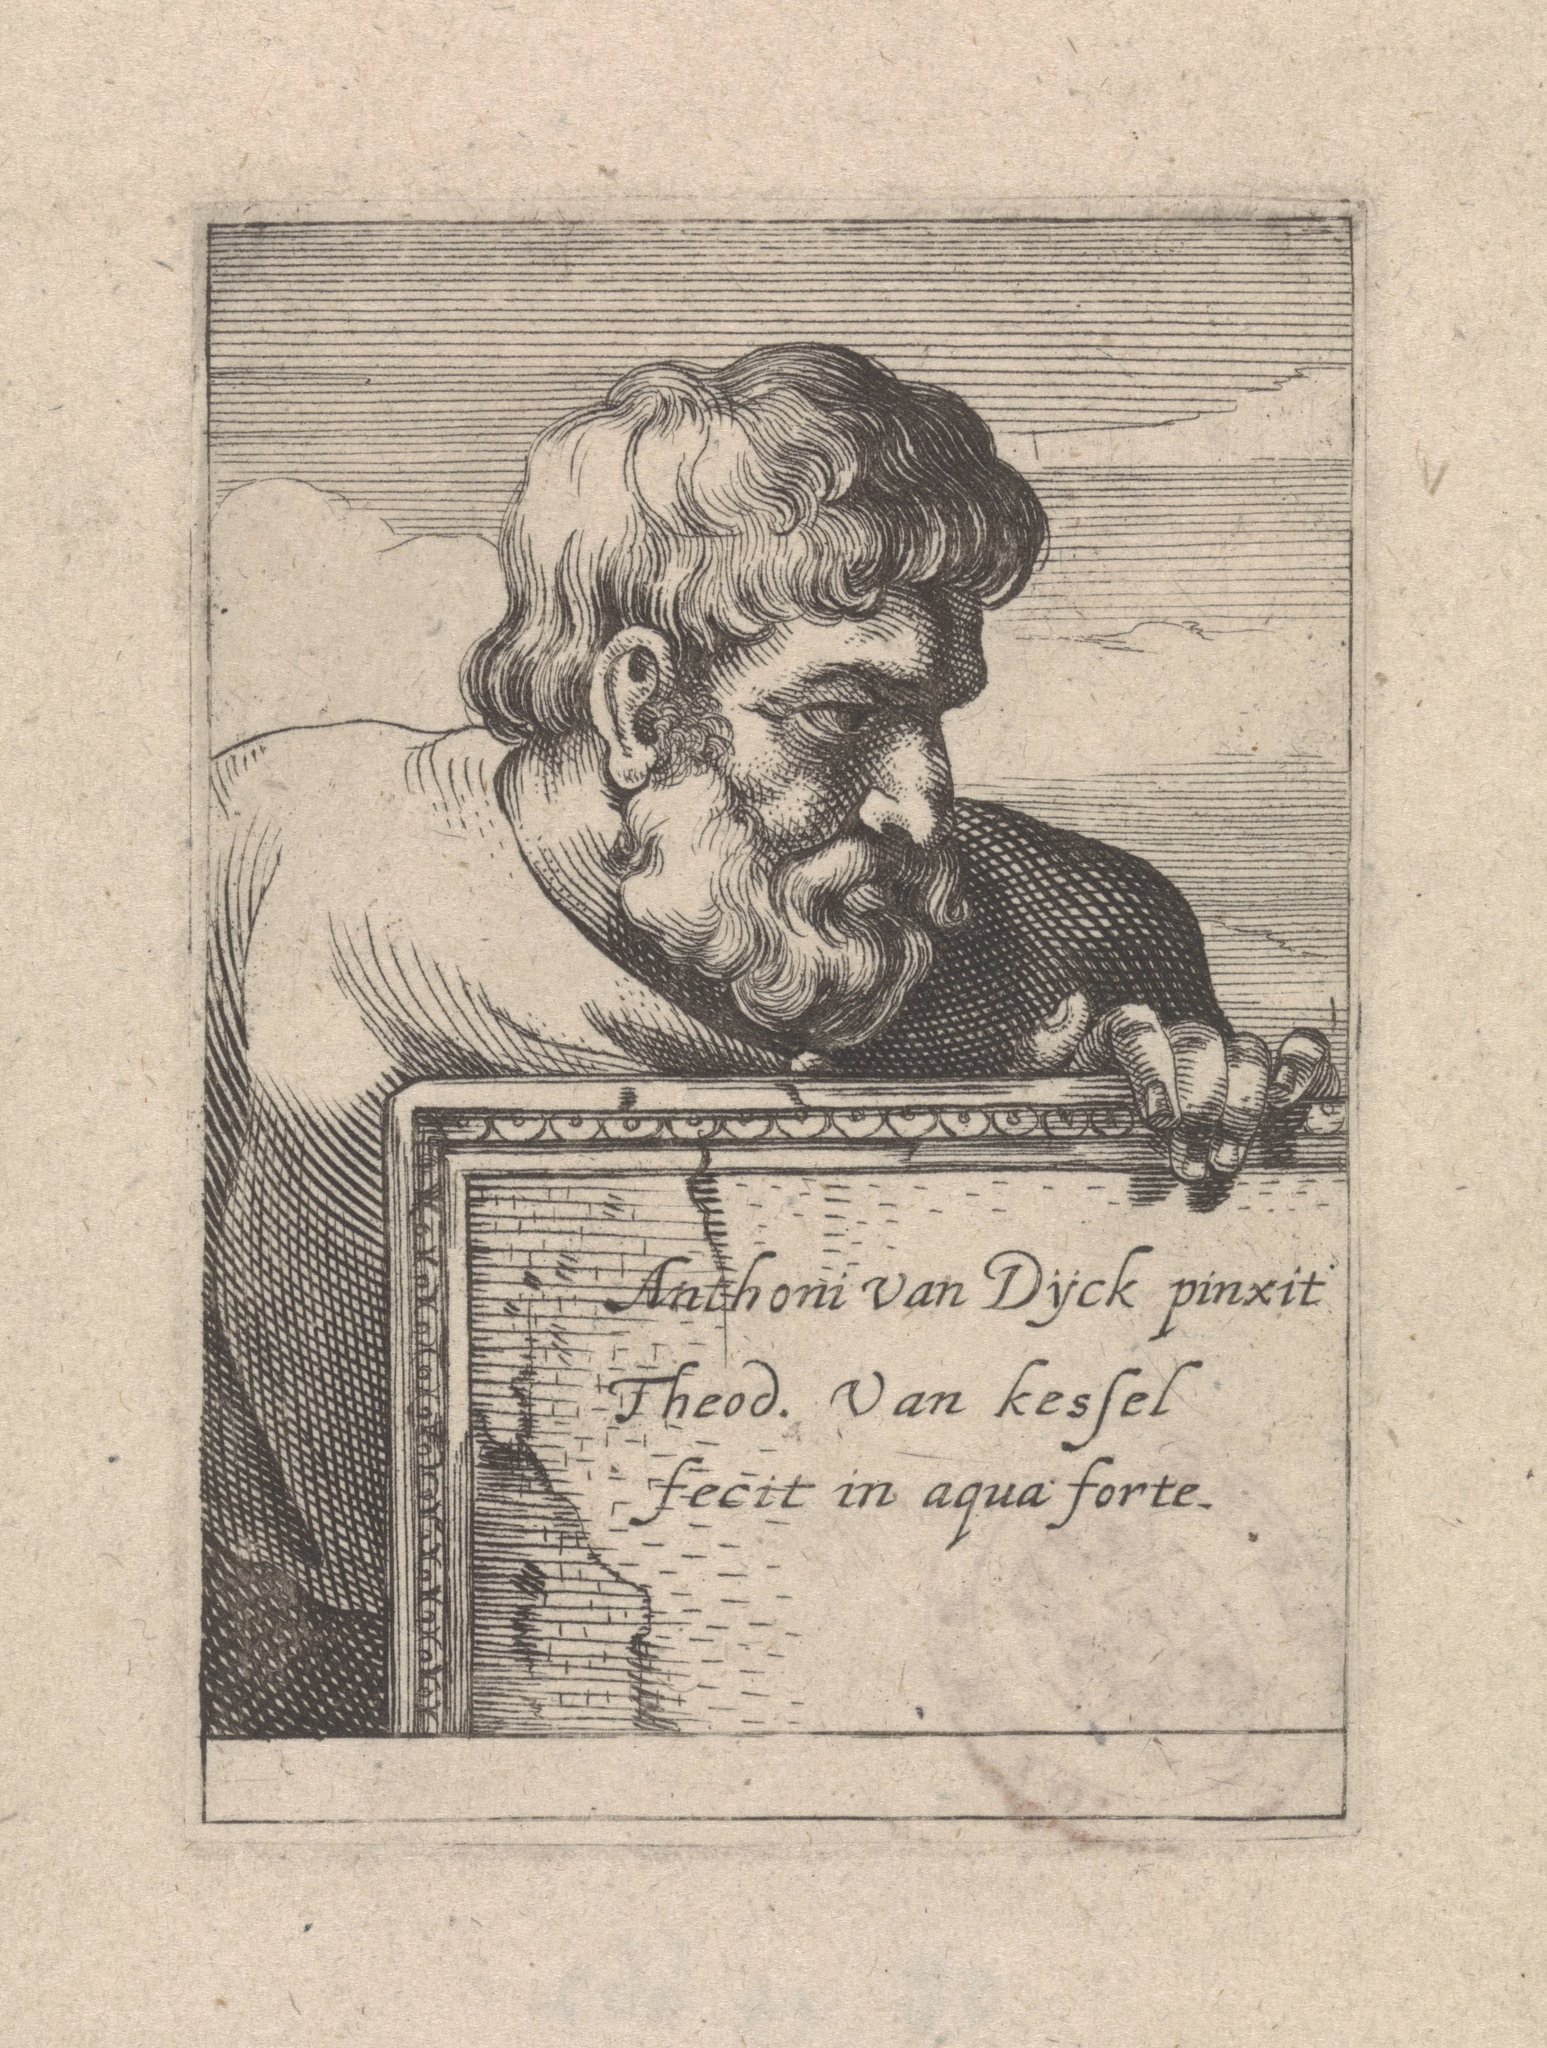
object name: print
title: Titelprent met hoofden van apostelen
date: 1630-1660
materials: paper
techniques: engraving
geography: netherlands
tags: (single) apostle, unspecified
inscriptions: collector's mark: Lugt 240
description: Titelprent met een buste van een apostel met zijn borst naar voren maar zijn hoofd naar rechts. Hij laat zijn rechterhand rusten op de lijst waarin de productiedetails van de prent staan.